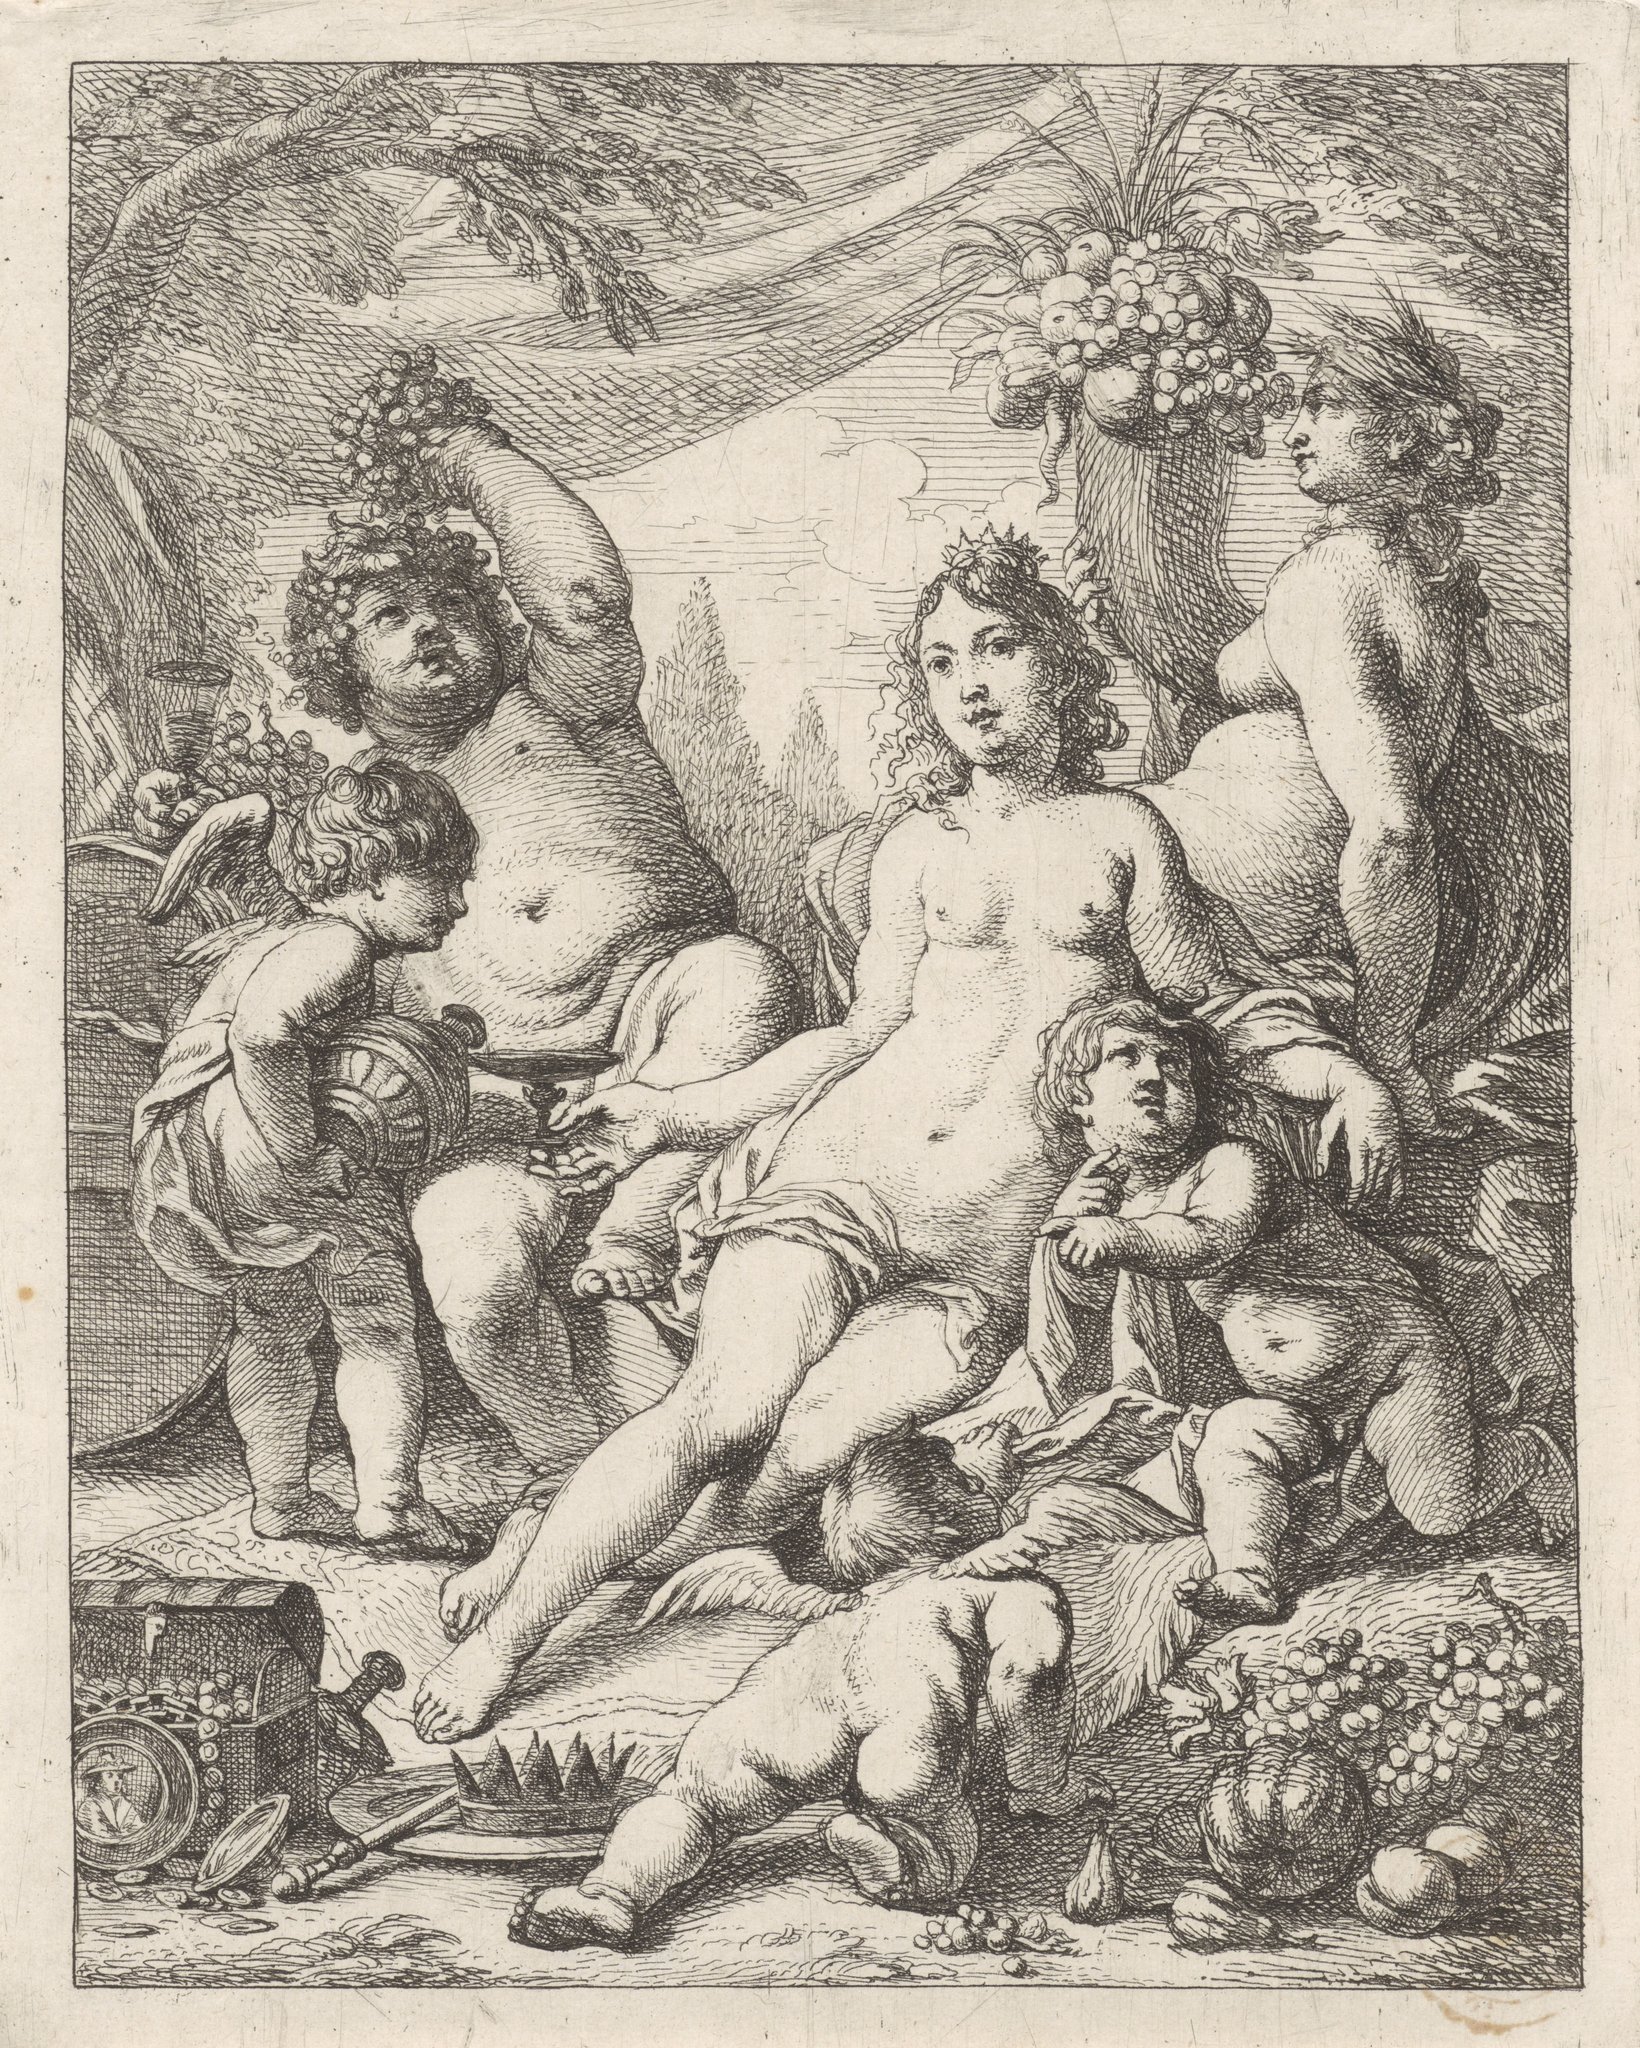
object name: print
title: Bacchus, Ceres en Venus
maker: cornelis schut (i)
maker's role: draughtsman, print maker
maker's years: 1597-1655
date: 1618-1655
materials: paper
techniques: engraving, etching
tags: 'sine cerere et baccho friget venus', money-chest, treasure-chest, money-box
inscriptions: collector's mark: Lugt 240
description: Ceres en Venus zitten naast een hoorn des overvloeds. Twee putti spelen op de grond. Een andere putto schenkt voor Venus een drinkschaal vol. Bacchus eet van een druiventros, leunend op een wijnvat. Op de grond staat een kist met kostbaarheden, ernaast liggen een kroon en een scepter.